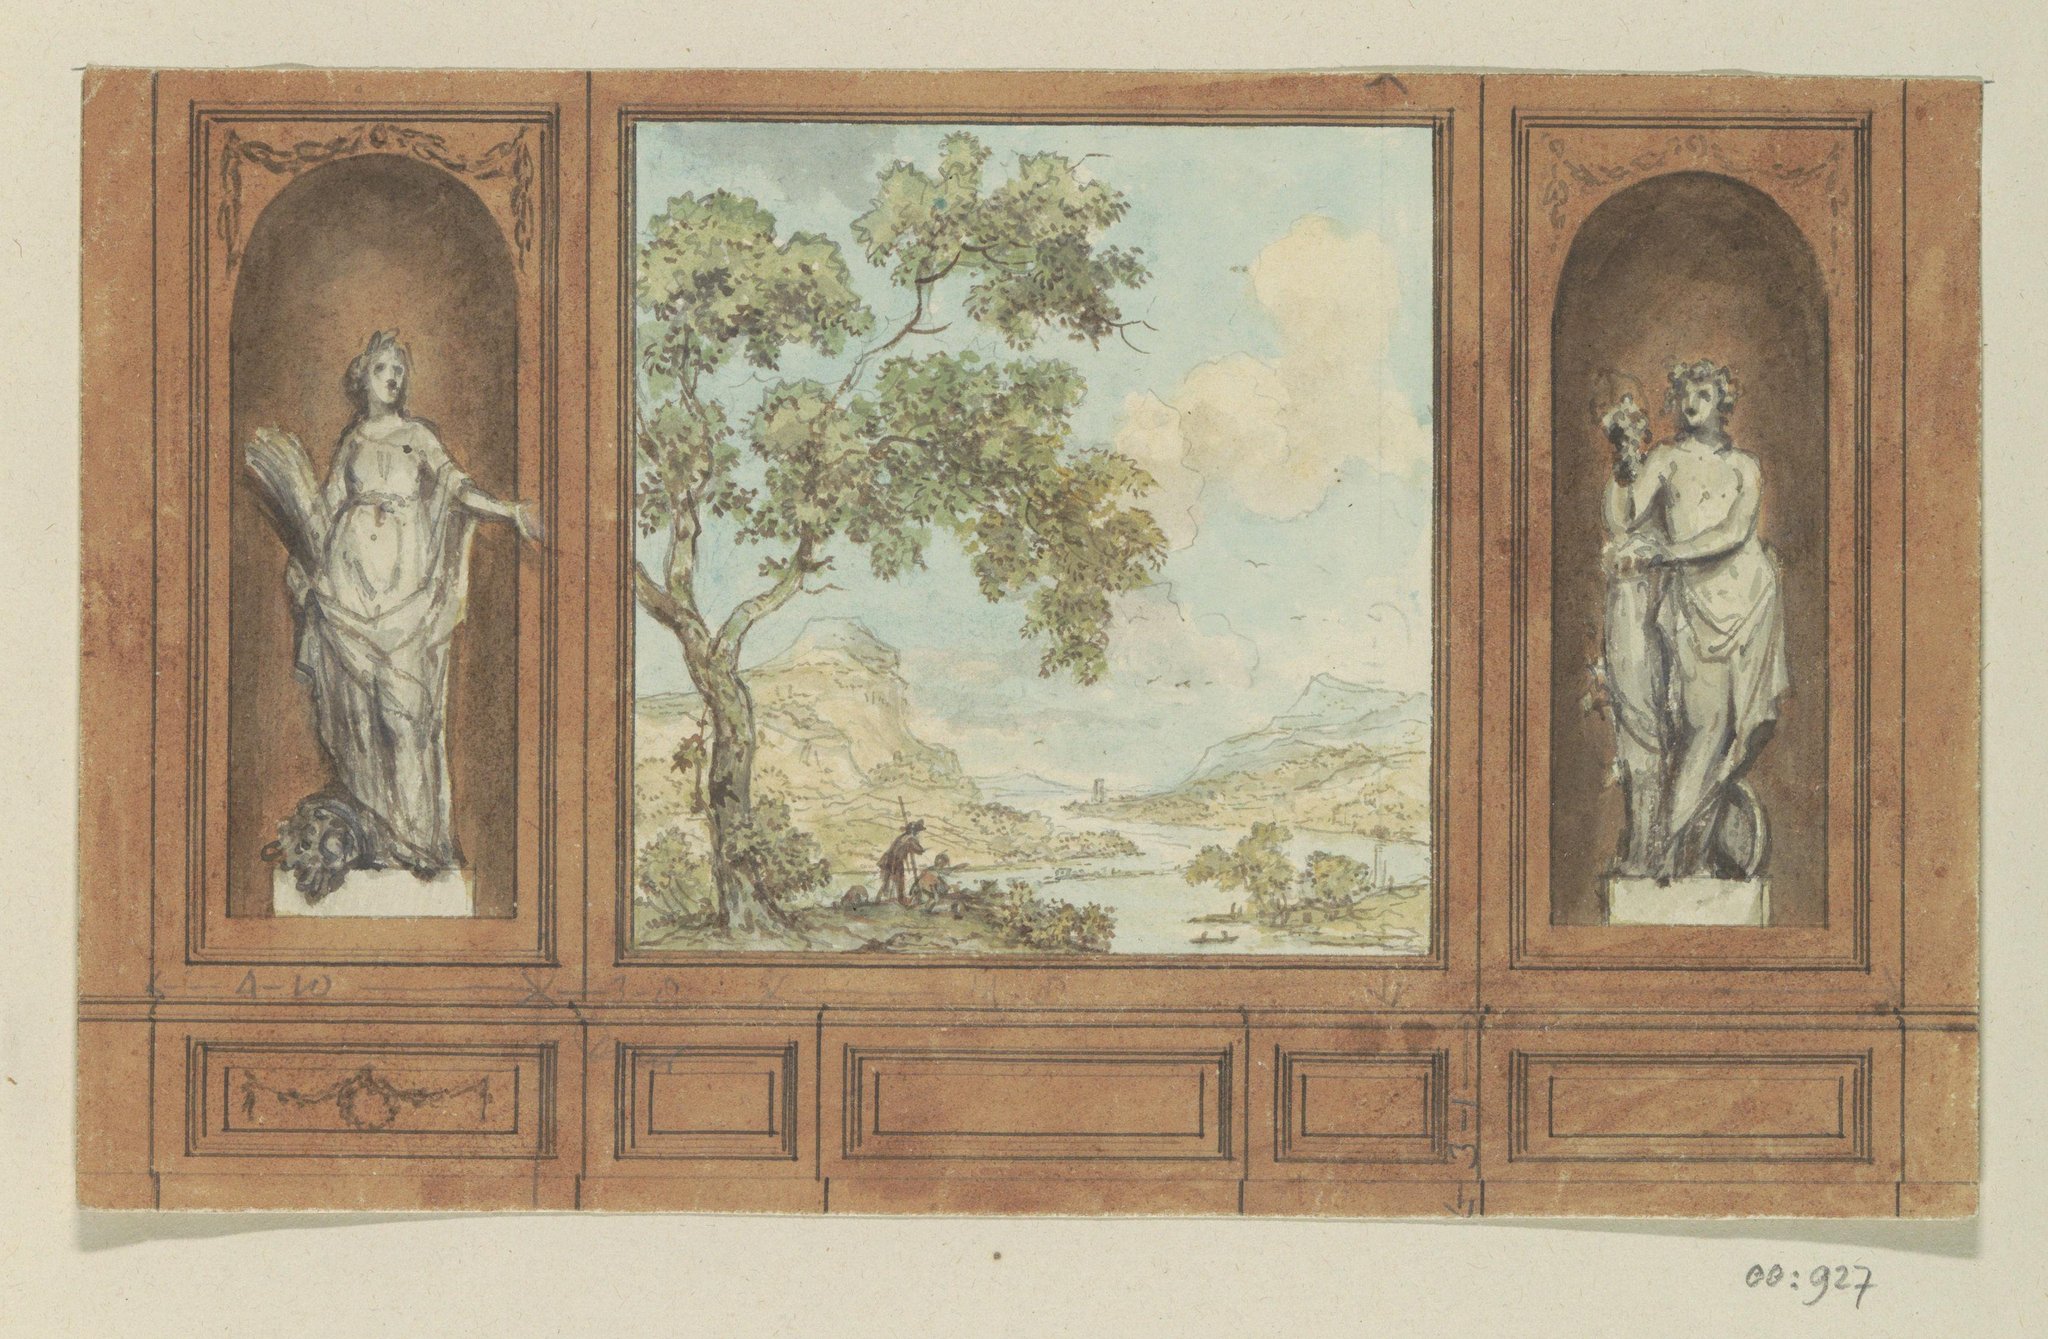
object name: drawing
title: Ontwerptekening voor een kamerwand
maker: jurriaan andriessen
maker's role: draughtsman, painter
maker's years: 1742-1819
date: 1760-1819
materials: paint, paper, pencil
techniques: brush, pen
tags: landscapes in the temperate zone, cereal, grain, corn (grass with grains, grown for food, e.g.: wheat, rice, rye, oats, maize, buckwheat, millet), wall-covering, bunch of grapes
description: Met in het midden een vergezicht van een waterlandschap met op de voorgrond twee personen. Vergezicht geflankeerd door twee beelden of grisailles: links een vrouw met korenaren en rechts een man met een druiventros. Tekening maakt deel uit van een album.